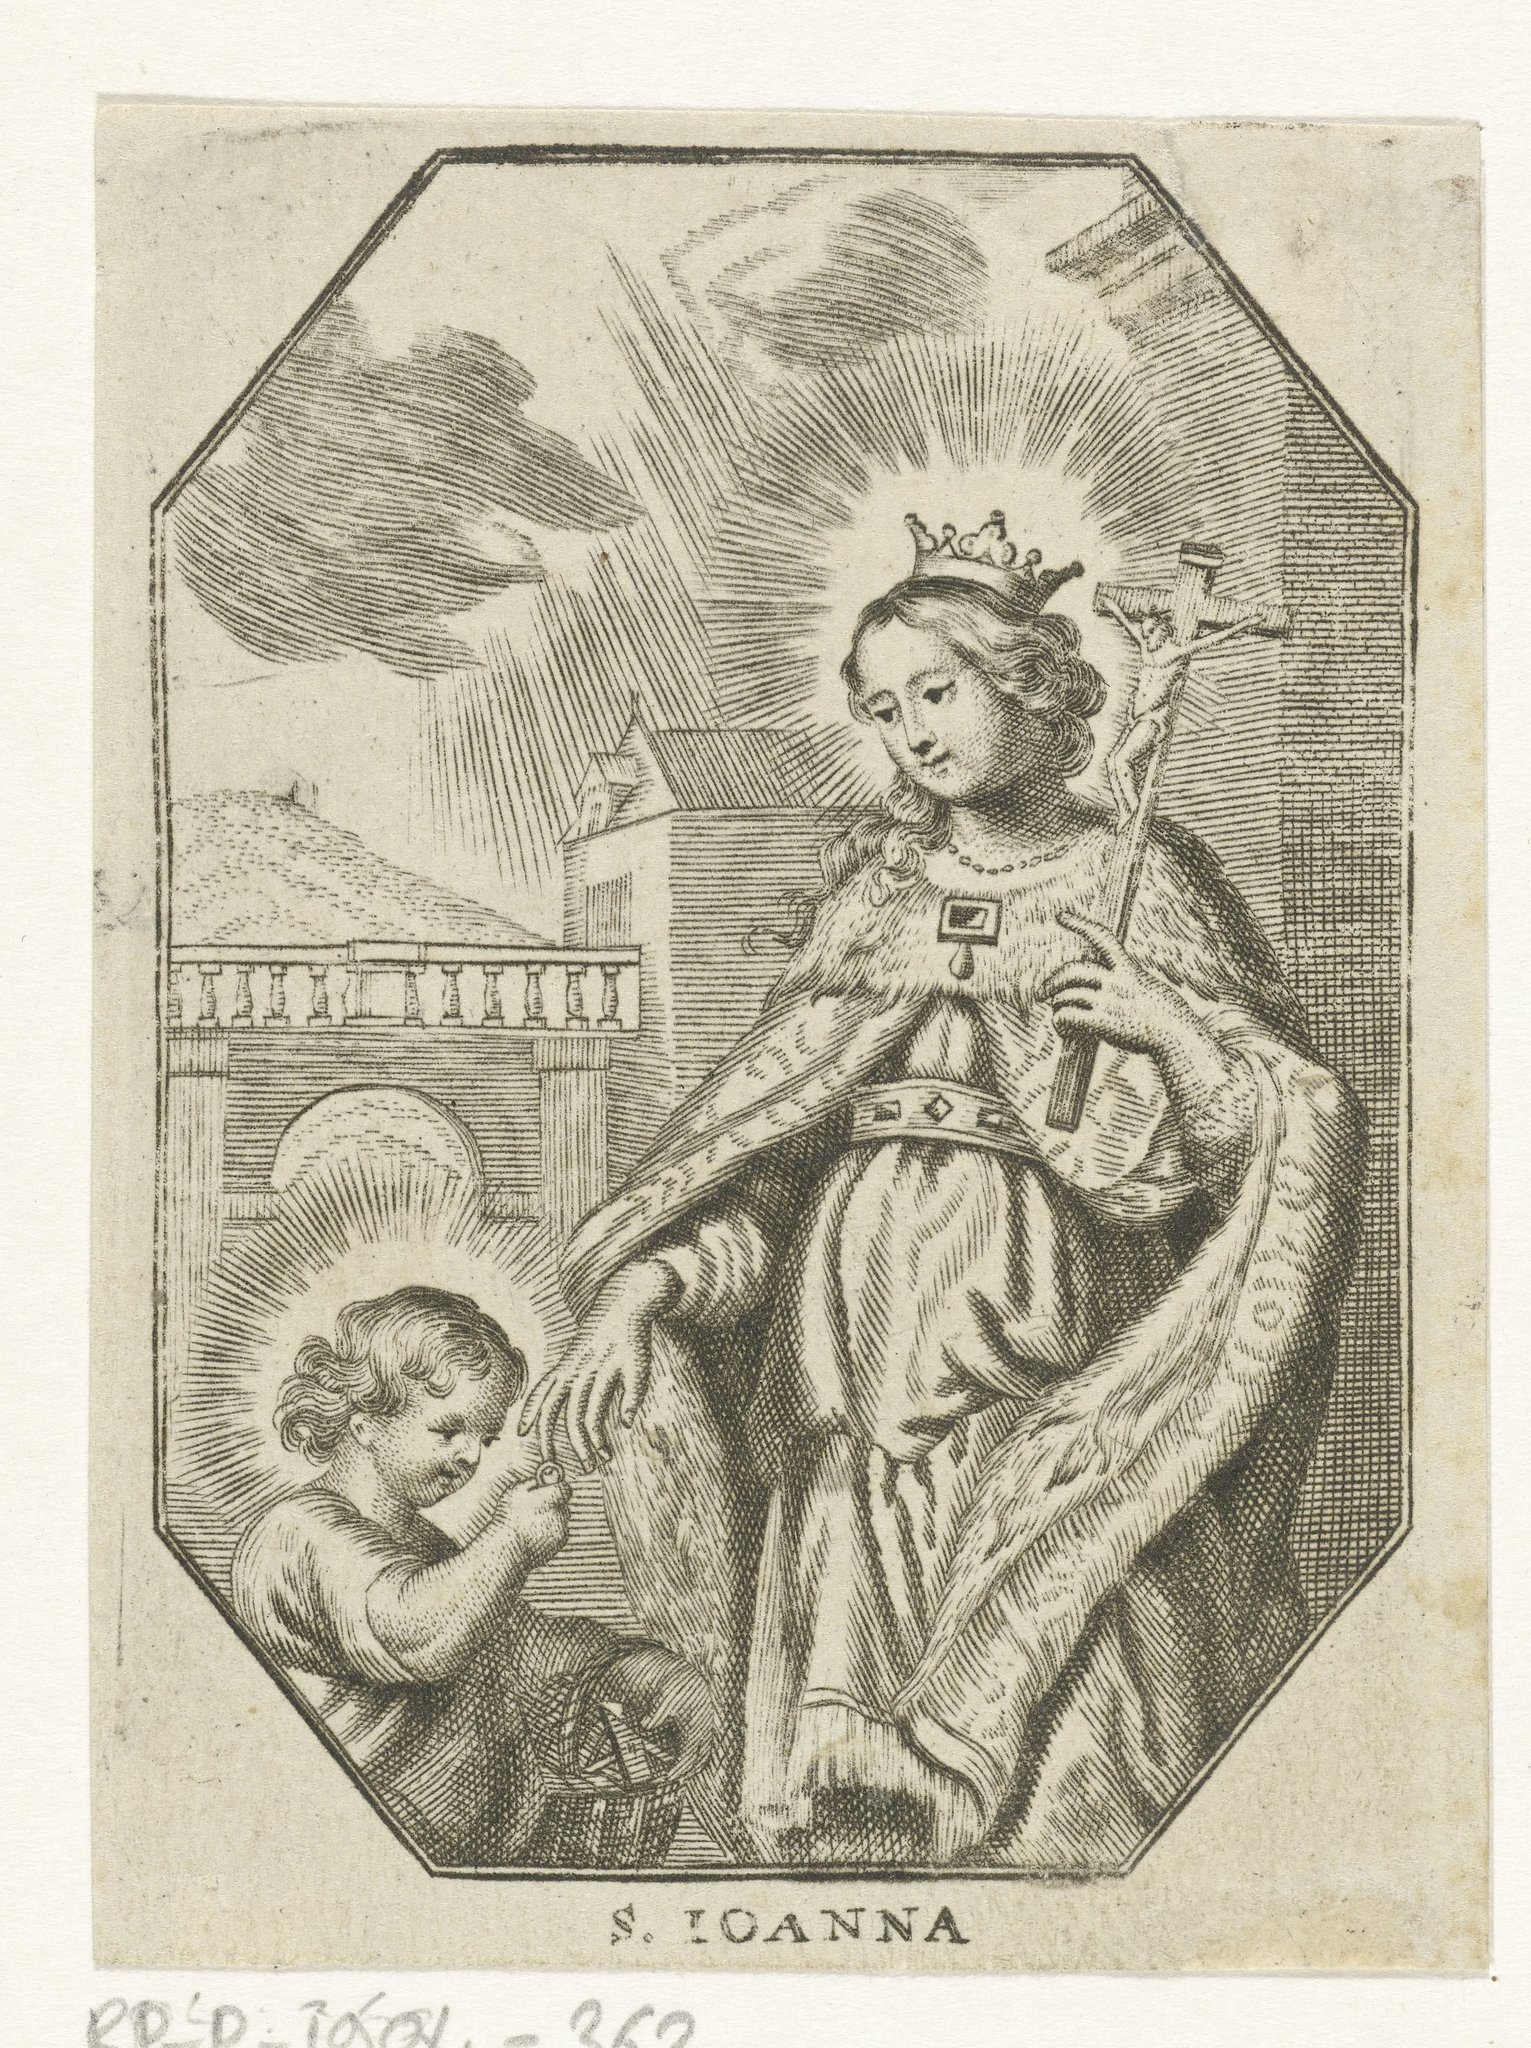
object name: print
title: H. Johanna van Valois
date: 1638-1678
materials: paper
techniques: engraving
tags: female saints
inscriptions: collector's mark: Lugt 2228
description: De heilige Johanna van Valois ontvangt een ring van het Christuskind. Ze is afgebeeld met kroon en crucifix in een rijk versierde mantel met bontkraag.